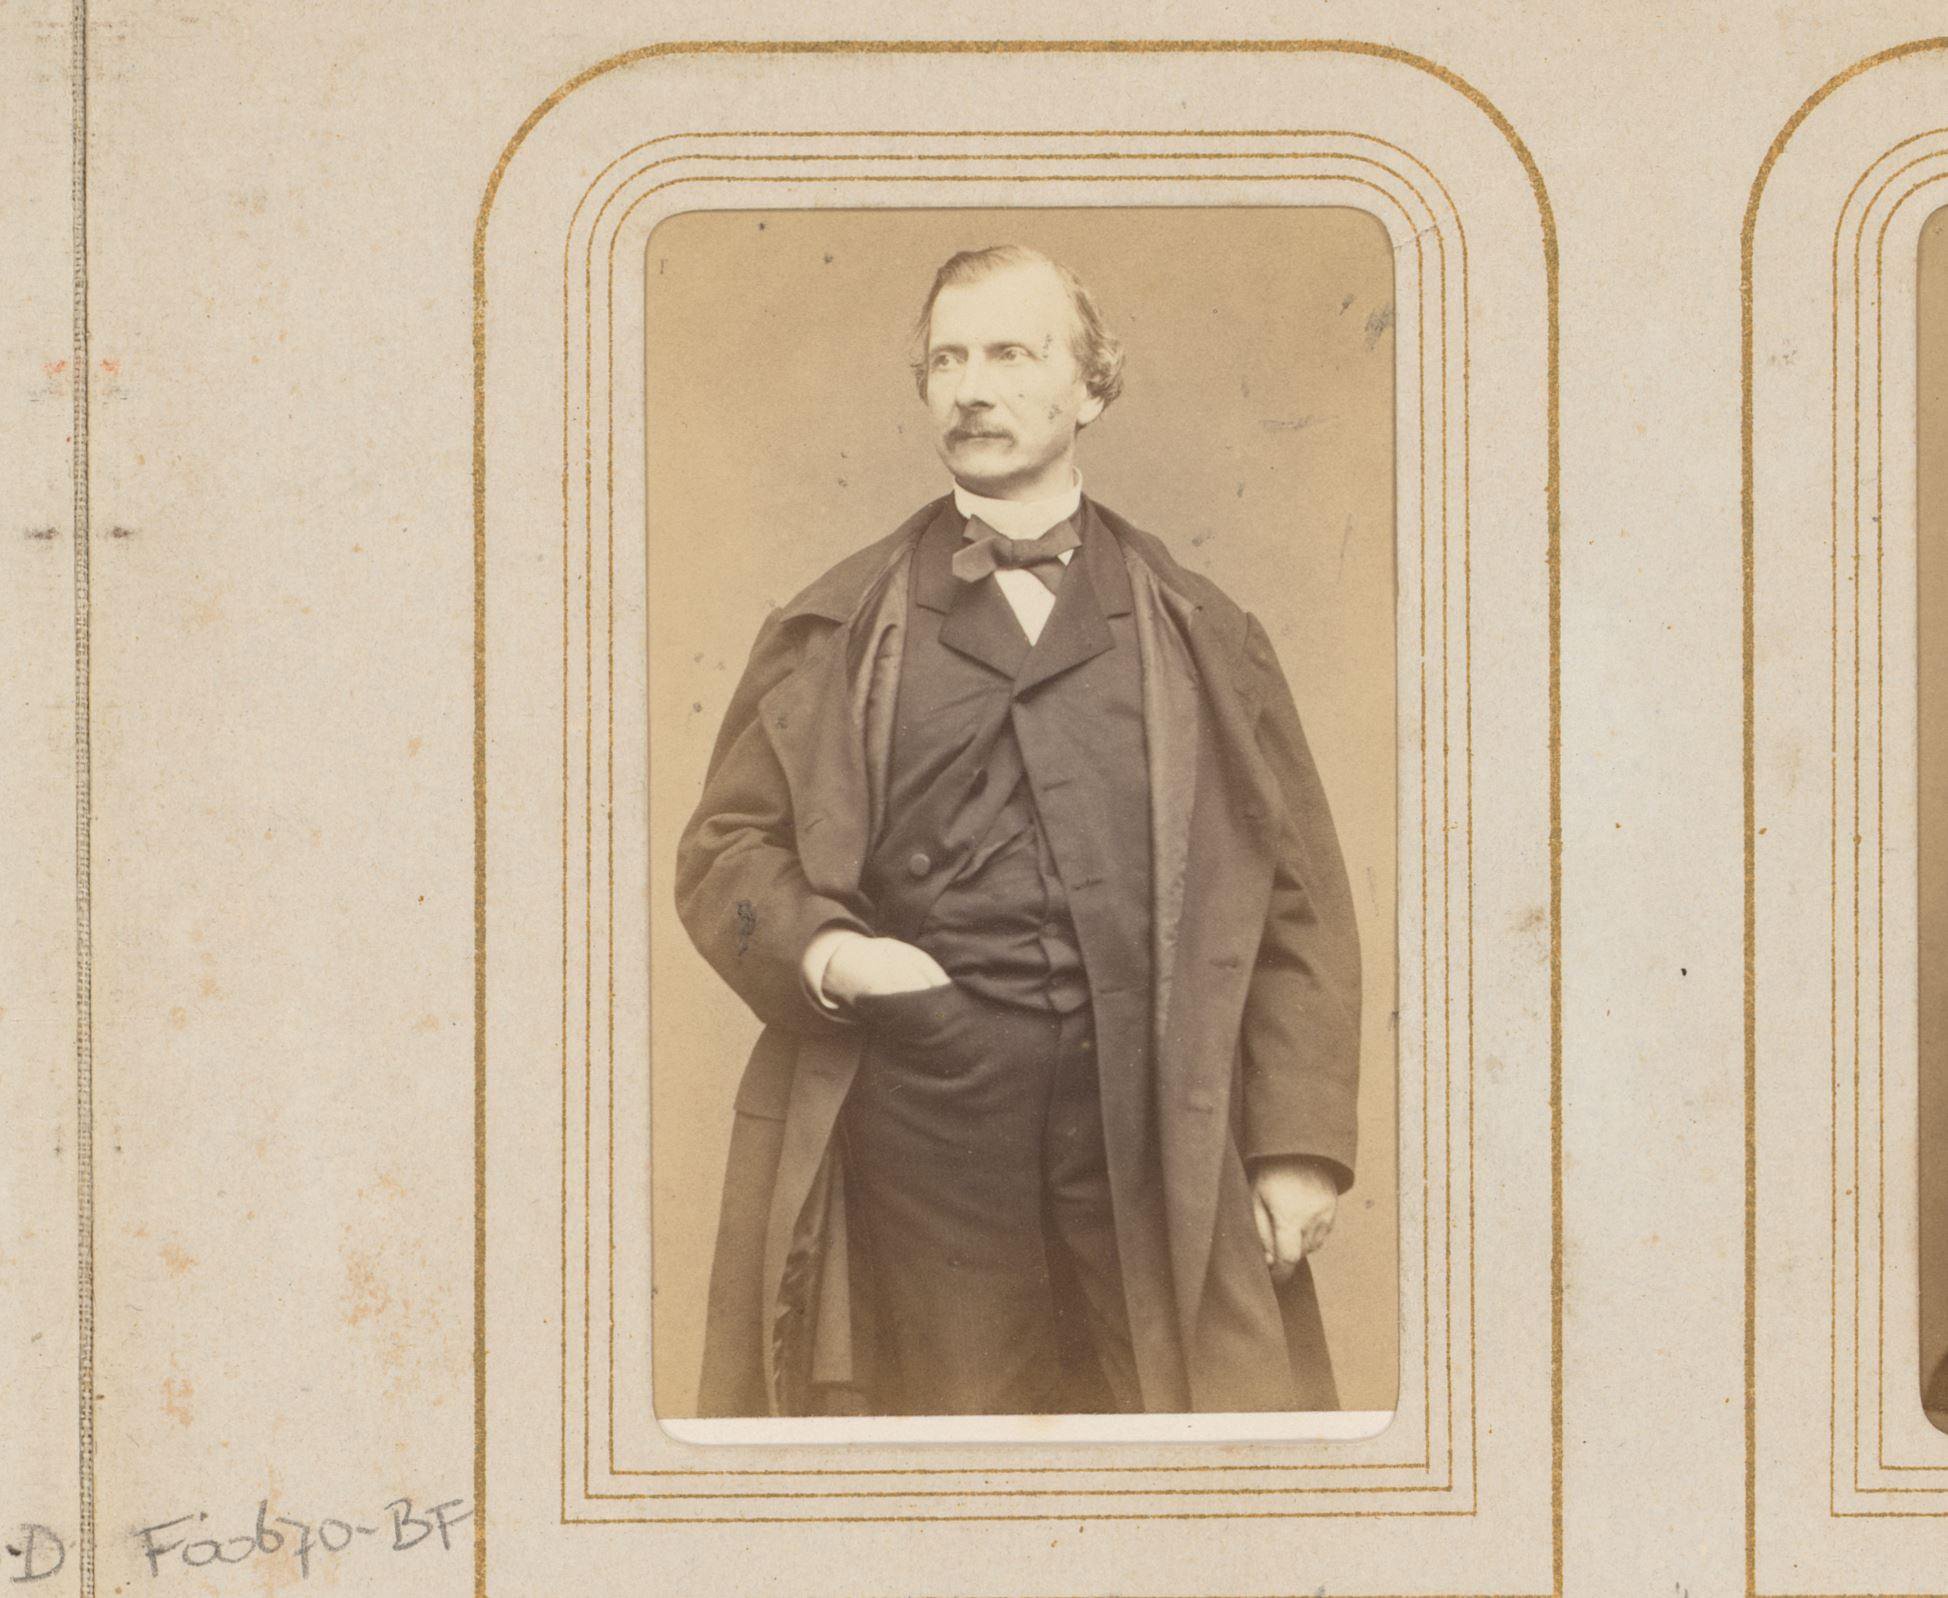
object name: photograph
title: Portret van Auguste Mermet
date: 1861-1880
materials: cardboard, photographic support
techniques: albumen print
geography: paris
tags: brussels, historical persons, portrait of composer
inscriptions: name: ‘Mermet’, inscription: ‘Photographie/ Carjat & Cie/ fondée en 1861/ Legé & Bergeron (...)’, inscription: ‘Auguste Mermet fr. componist/ 1810-1889 (Lege Bergeron)’